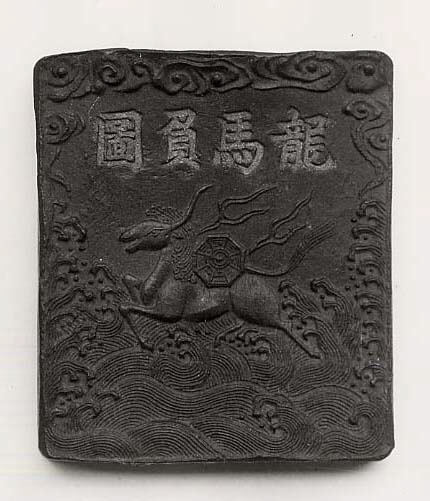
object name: ink tablet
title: Ink Tablet Decorated with Mythical Horse and the Eight Trigrams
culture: chinese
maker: xiu fangzhai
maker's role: artist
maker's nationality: chinese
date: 1867-1933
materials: ink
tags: mythical creatures